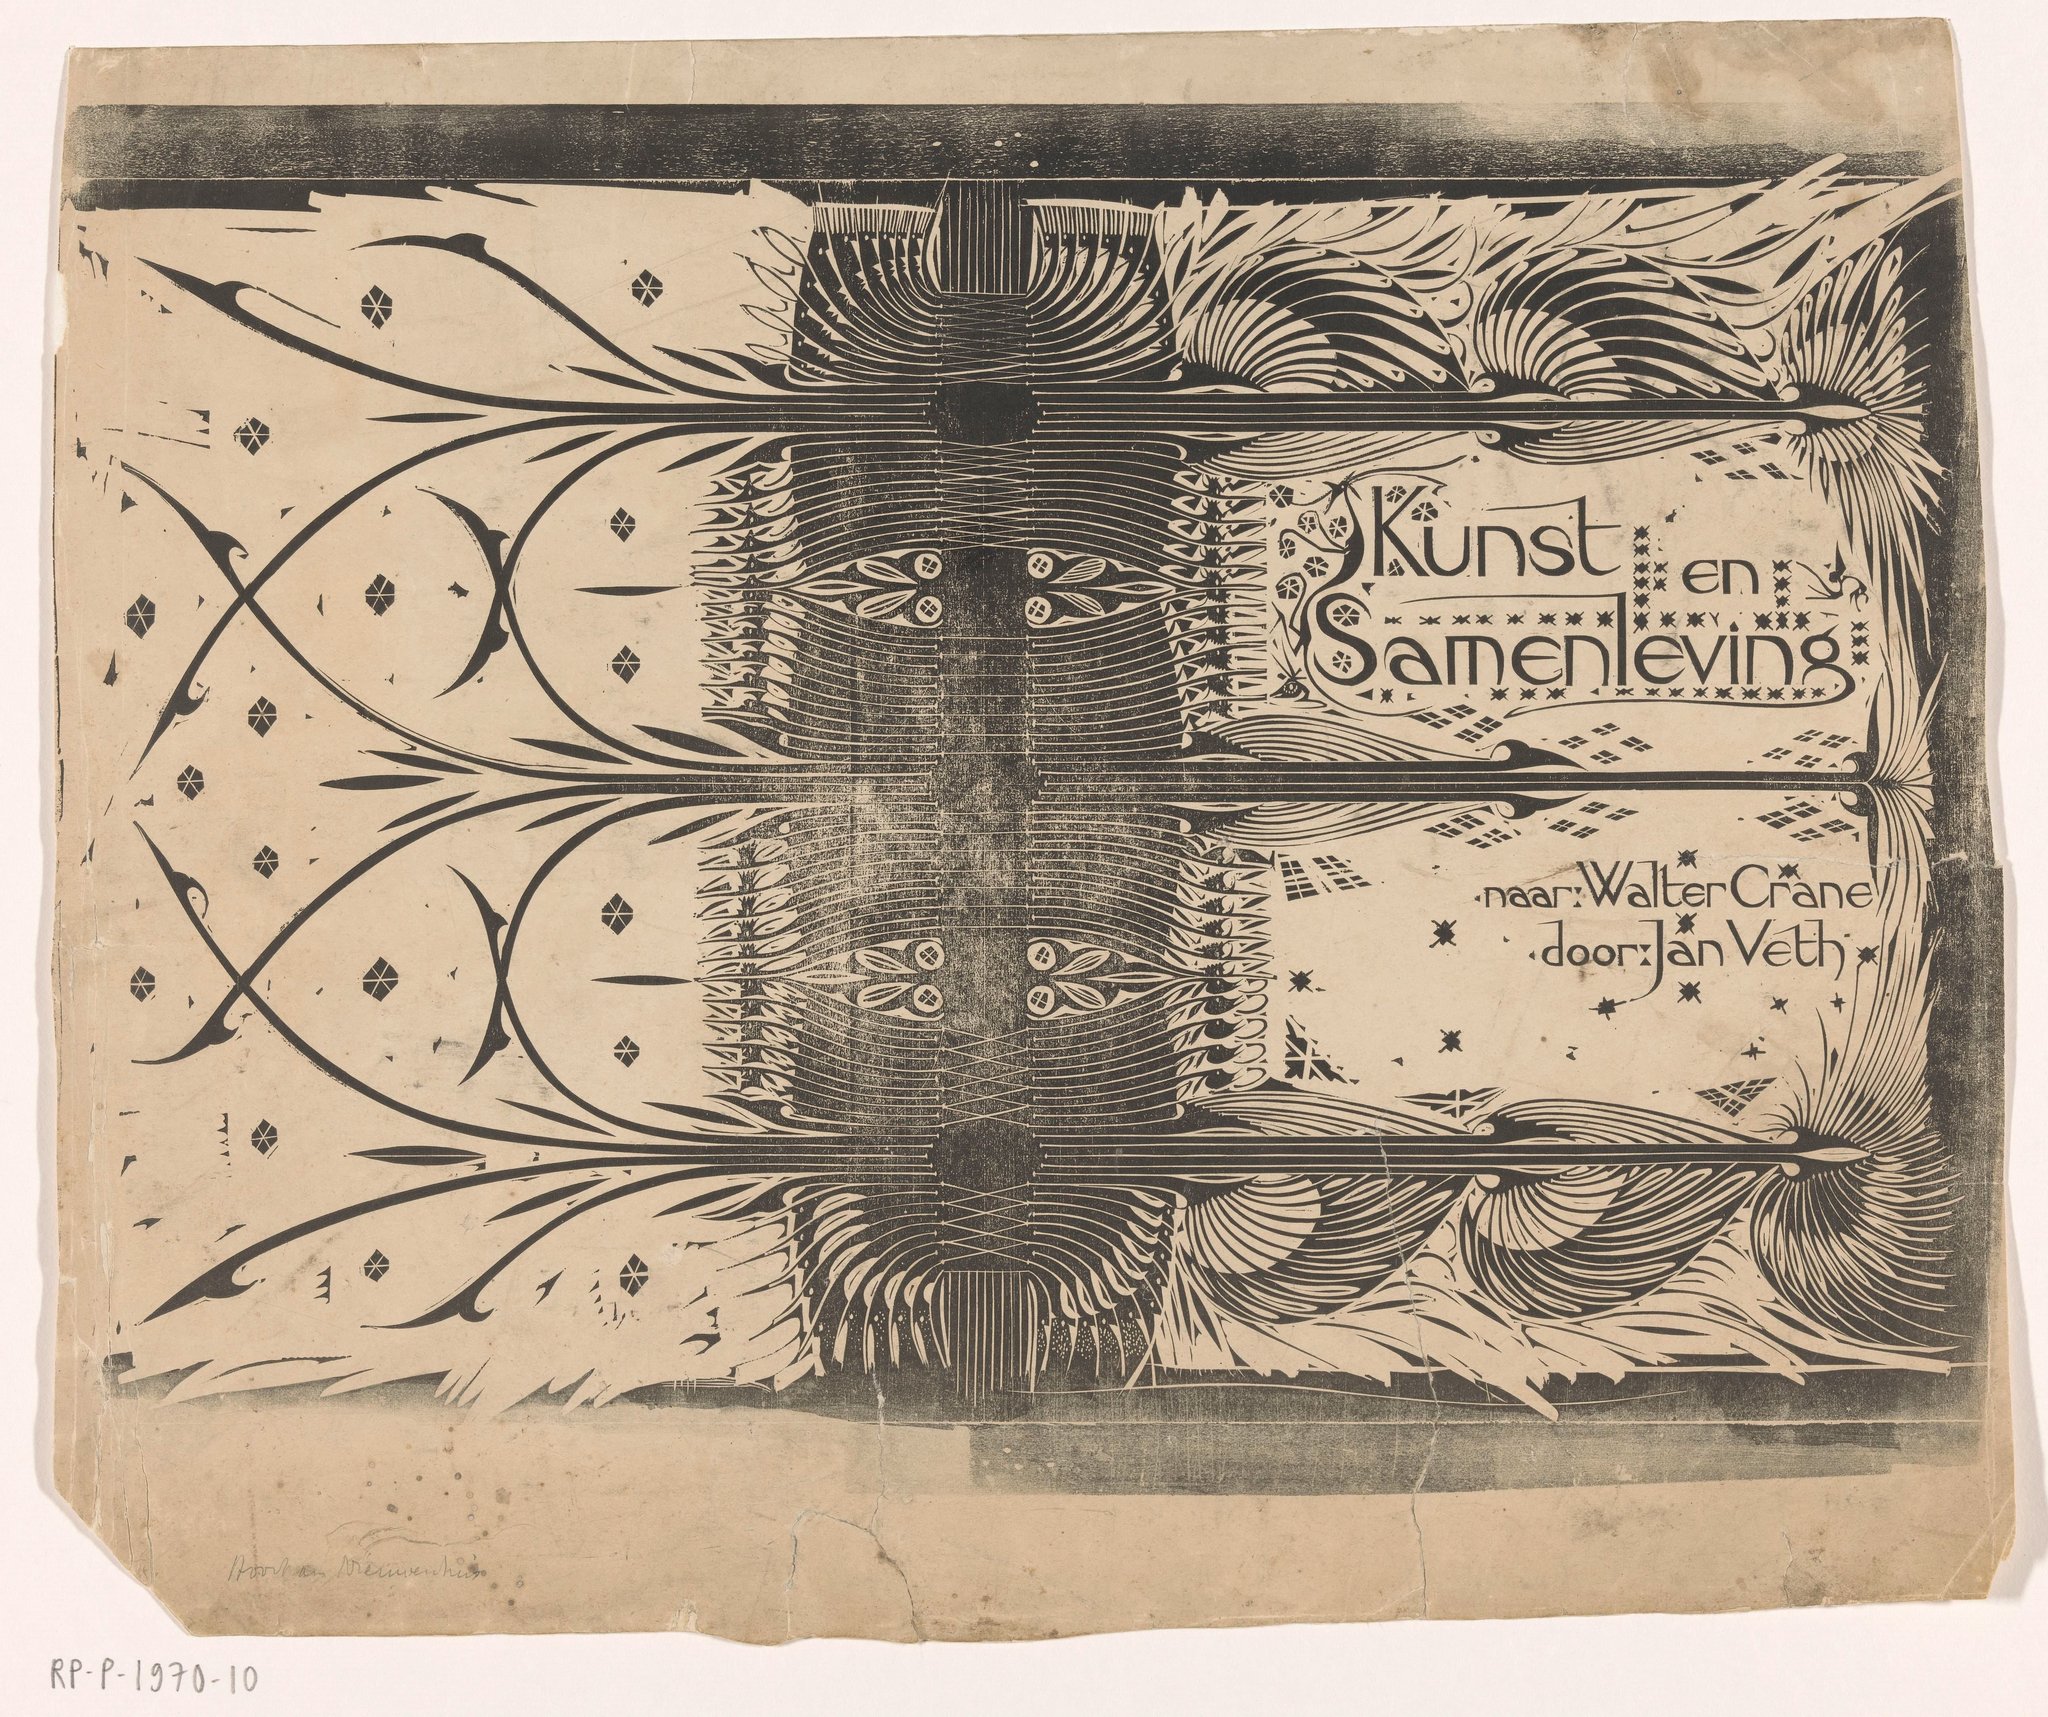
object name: print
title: Ontwerp voor de boekomslag van de ingenaaide editie van 'Kunst en samenleving'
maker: gerrit willem dijsselhof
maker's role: designer, draughtsman, print maker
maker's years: 1866-1924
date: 1893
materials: paper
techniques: woodcut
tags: dordrecht, amsterdam, painter, print maker, draughtsman, designer, jan veth, walter crane, ornament derived from animal forms, ornamental birds: peacock (+ feathers)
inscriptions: collector's mark: Lugt 2760, collector's mark: Lugt 2228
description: Een boekomslag met drie pauwenveren die zich horizontaal uitstrekken over de voor- en achterzijde. De pennen van de veren zijn kruislings gerangschikt op de achterzijde.